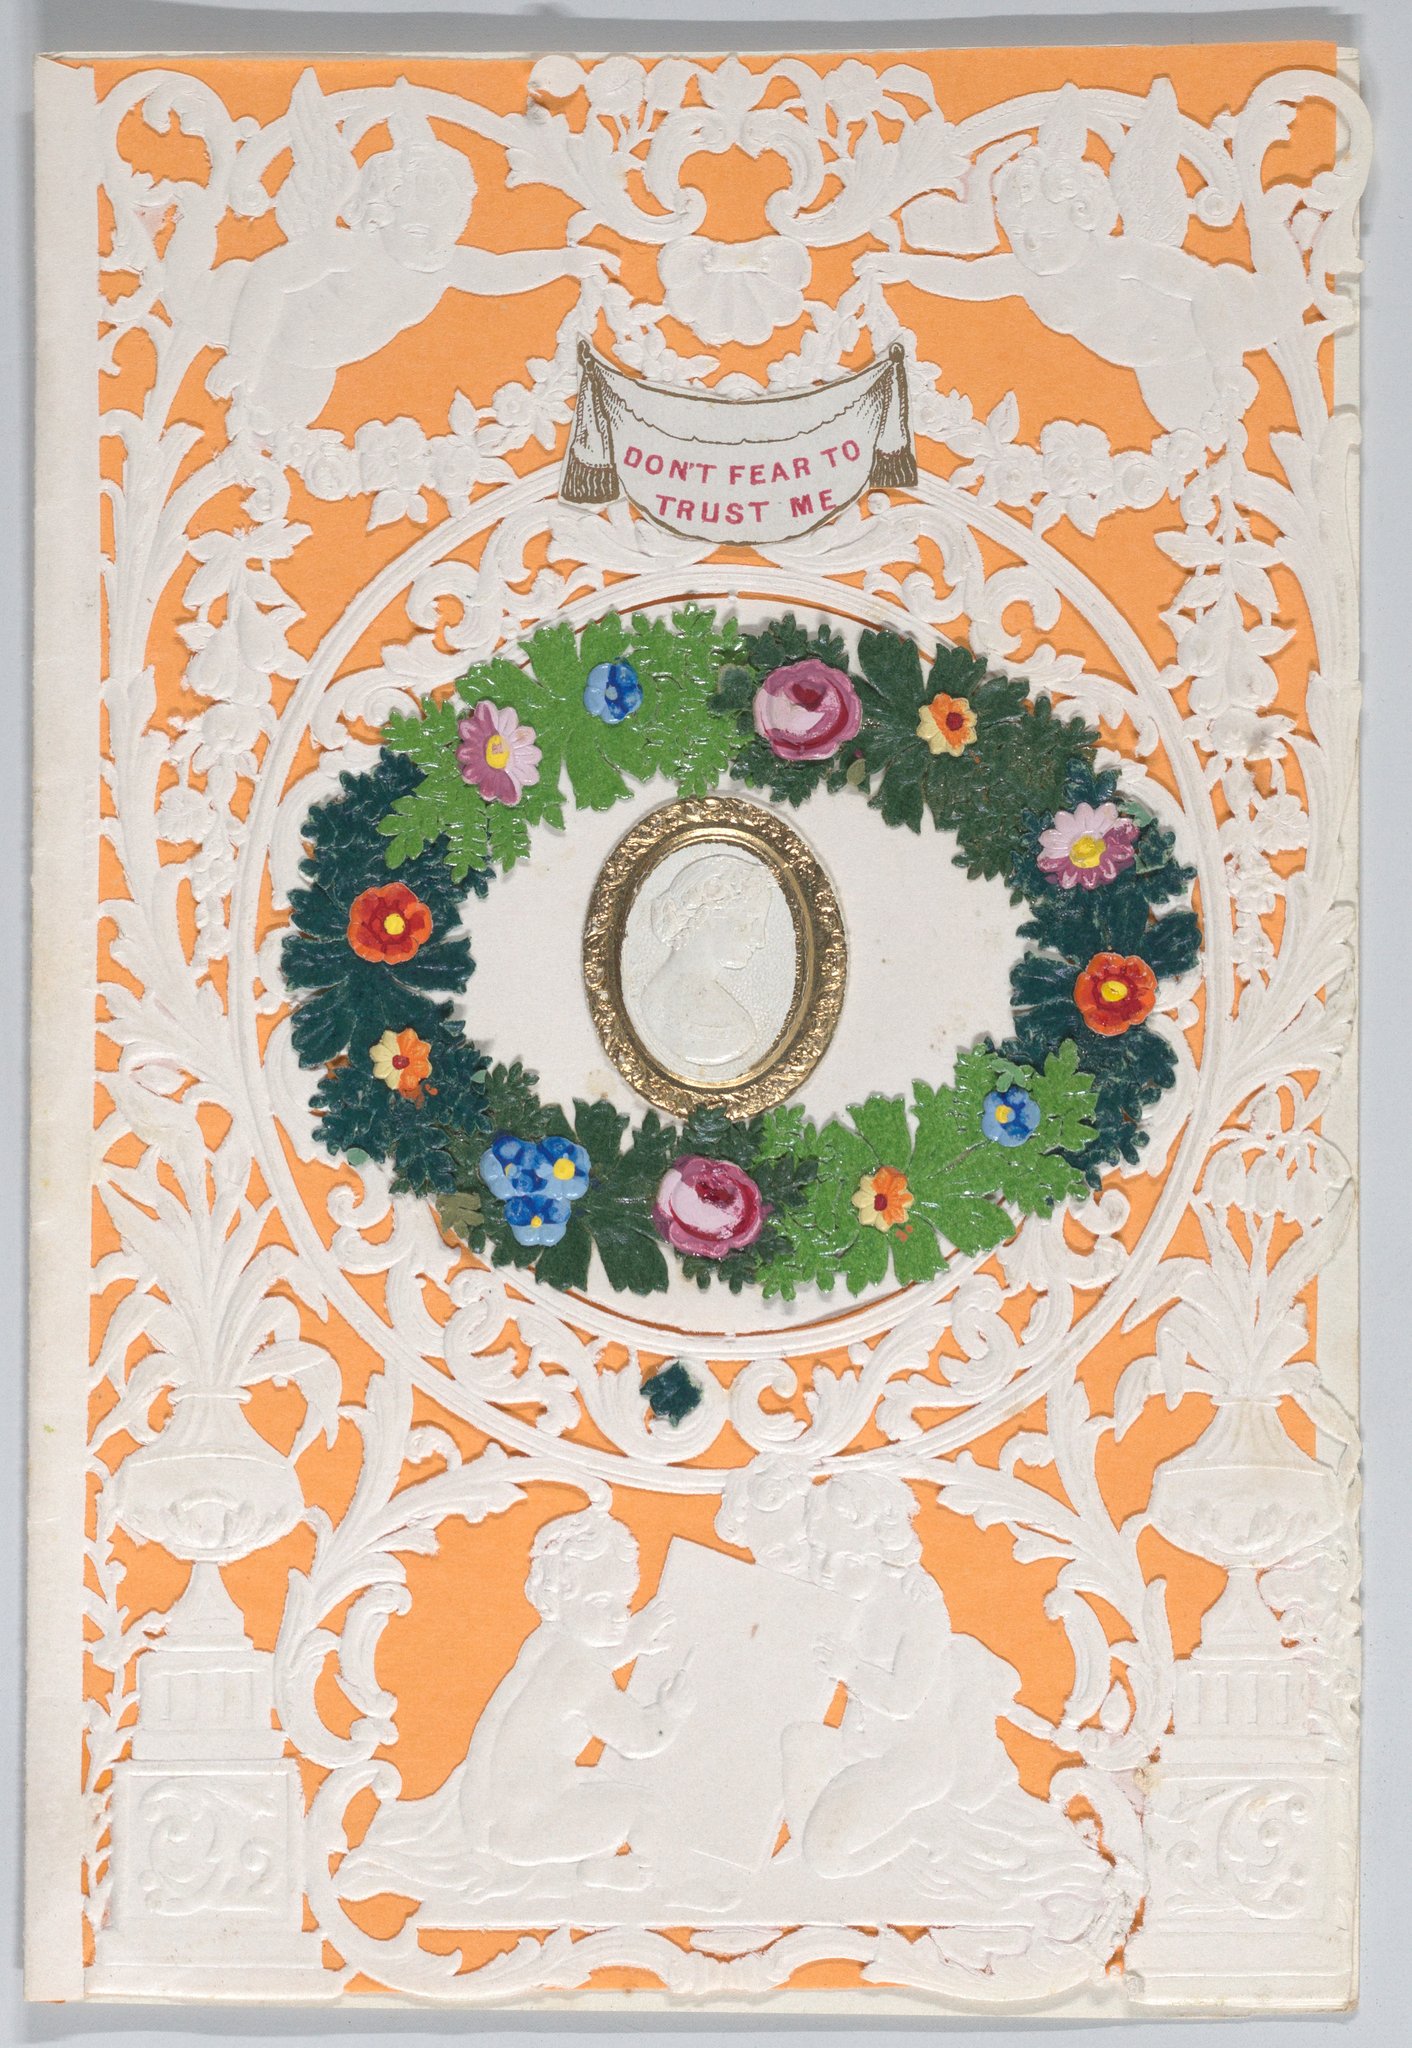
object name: valentine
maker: Anonymous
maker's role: artist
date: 1850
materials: paper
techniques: cutting, embossing